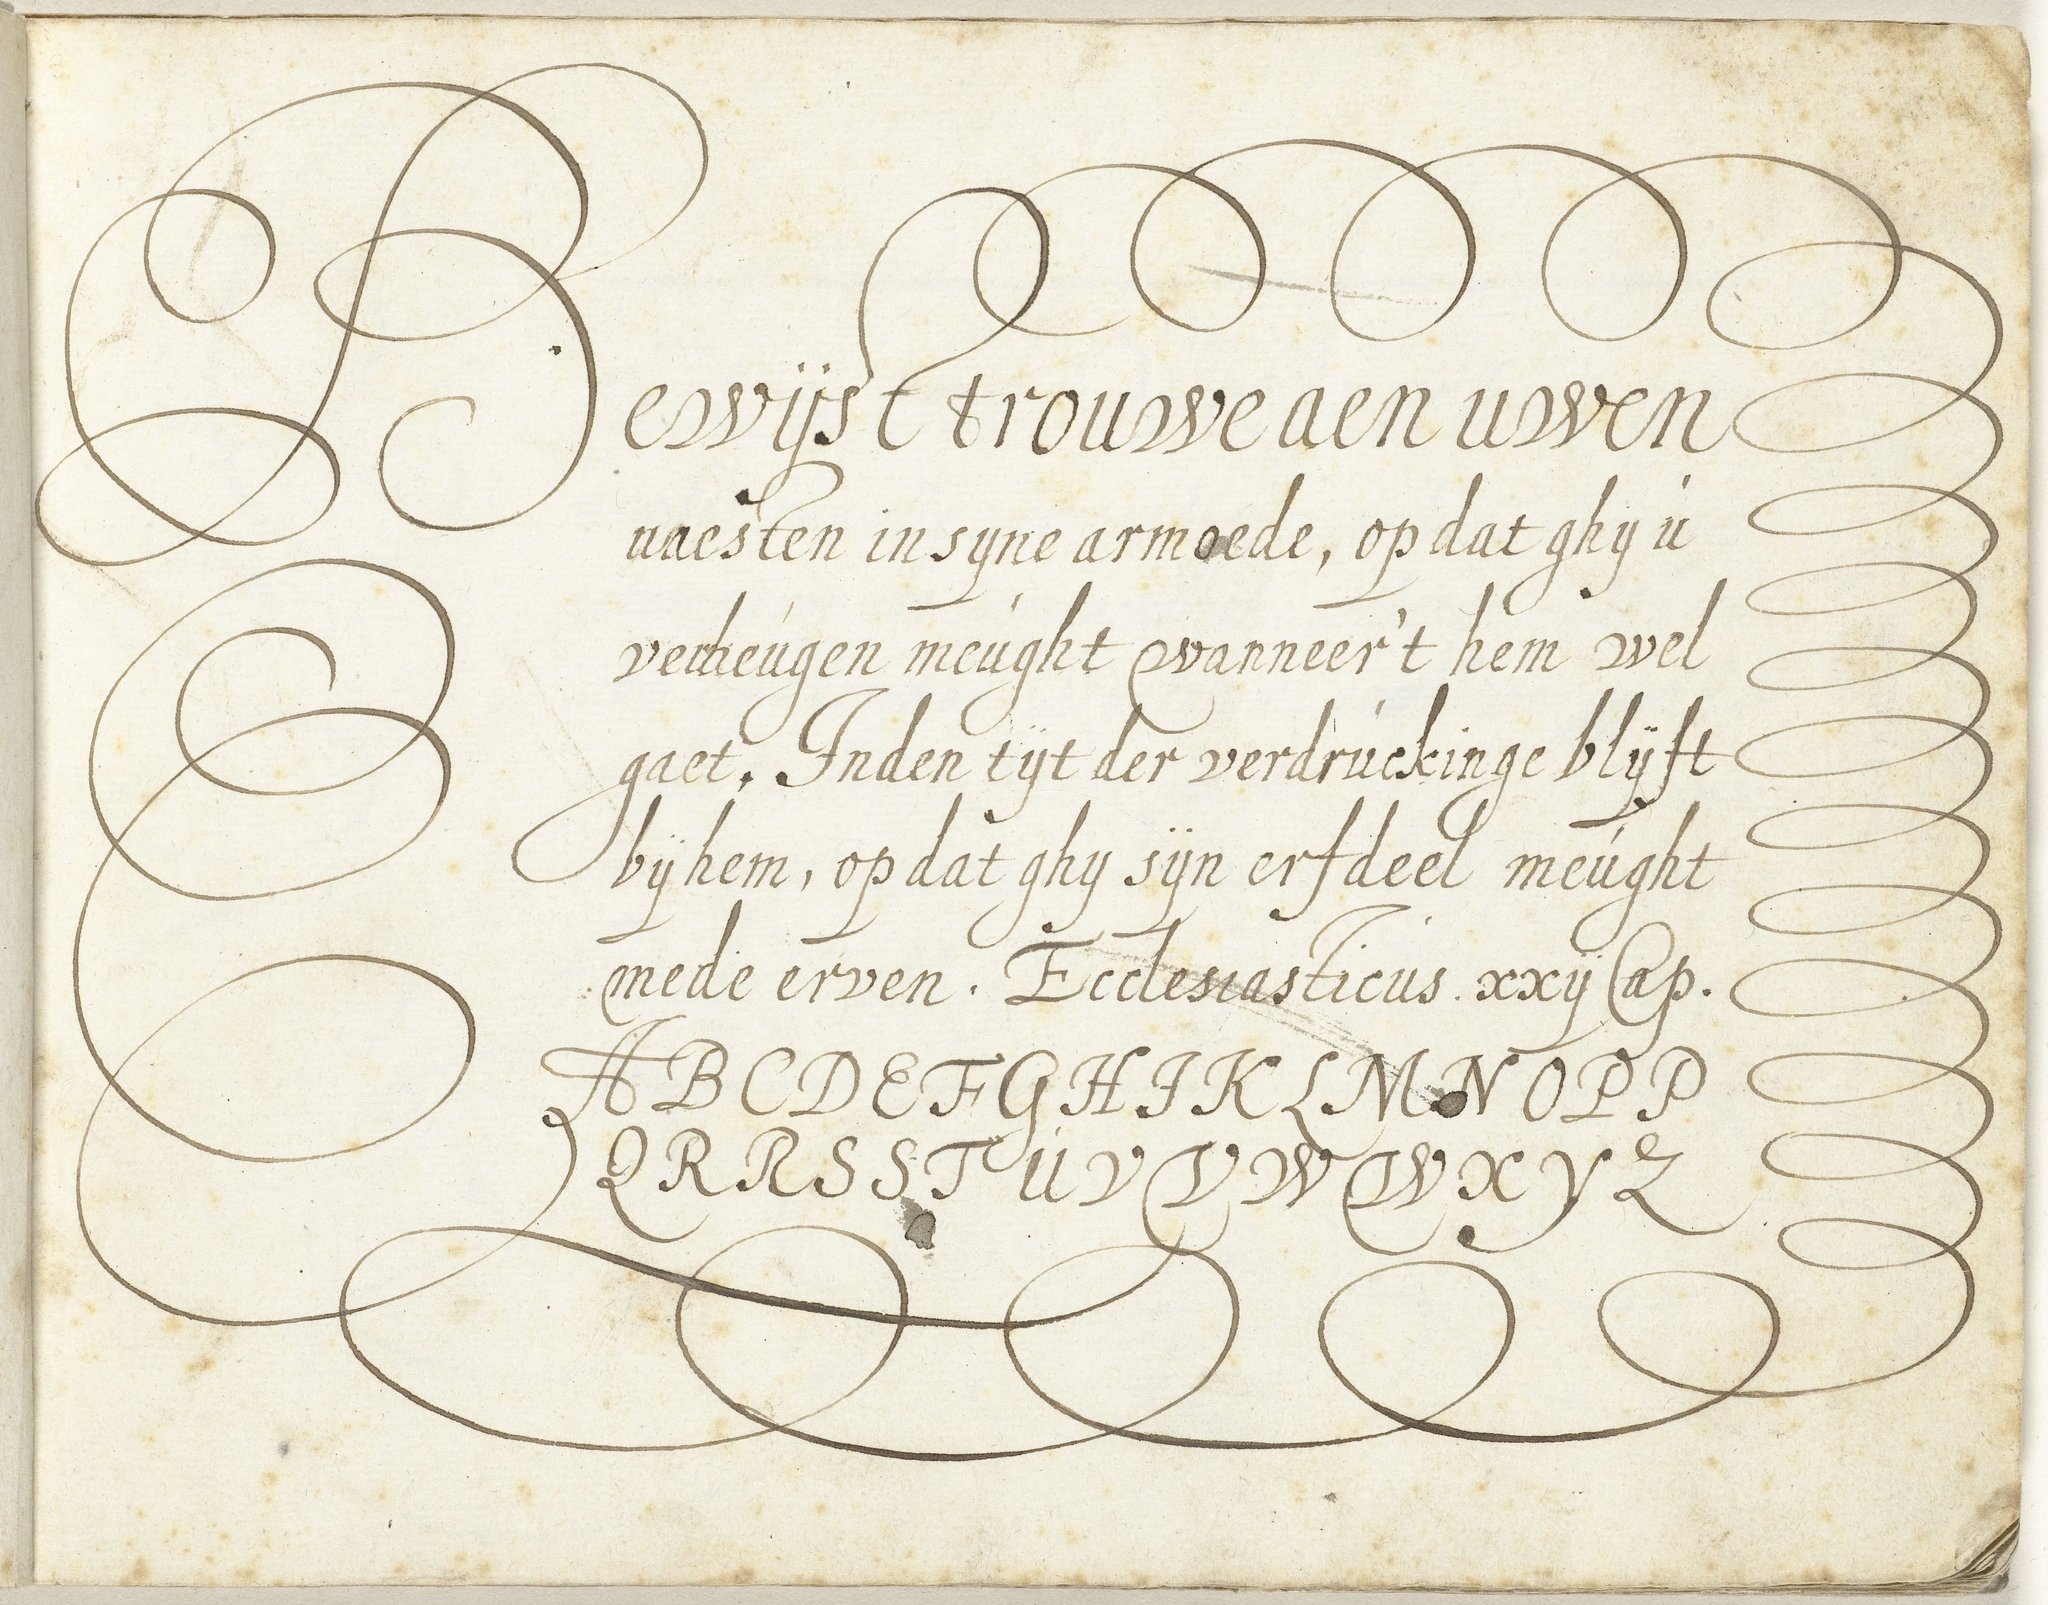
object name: calligraphy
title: Bijbelcitaat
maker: gesina ter borch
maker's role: draughtsman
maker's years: 1633-1690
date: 1646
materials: ink, paper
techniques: calligraphy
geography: zwolle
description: Passage uit het apocriefe boek Ecclesiasticus (of Jezus Sirach) 22:27-28, uit de Statenvertaling van 1637.